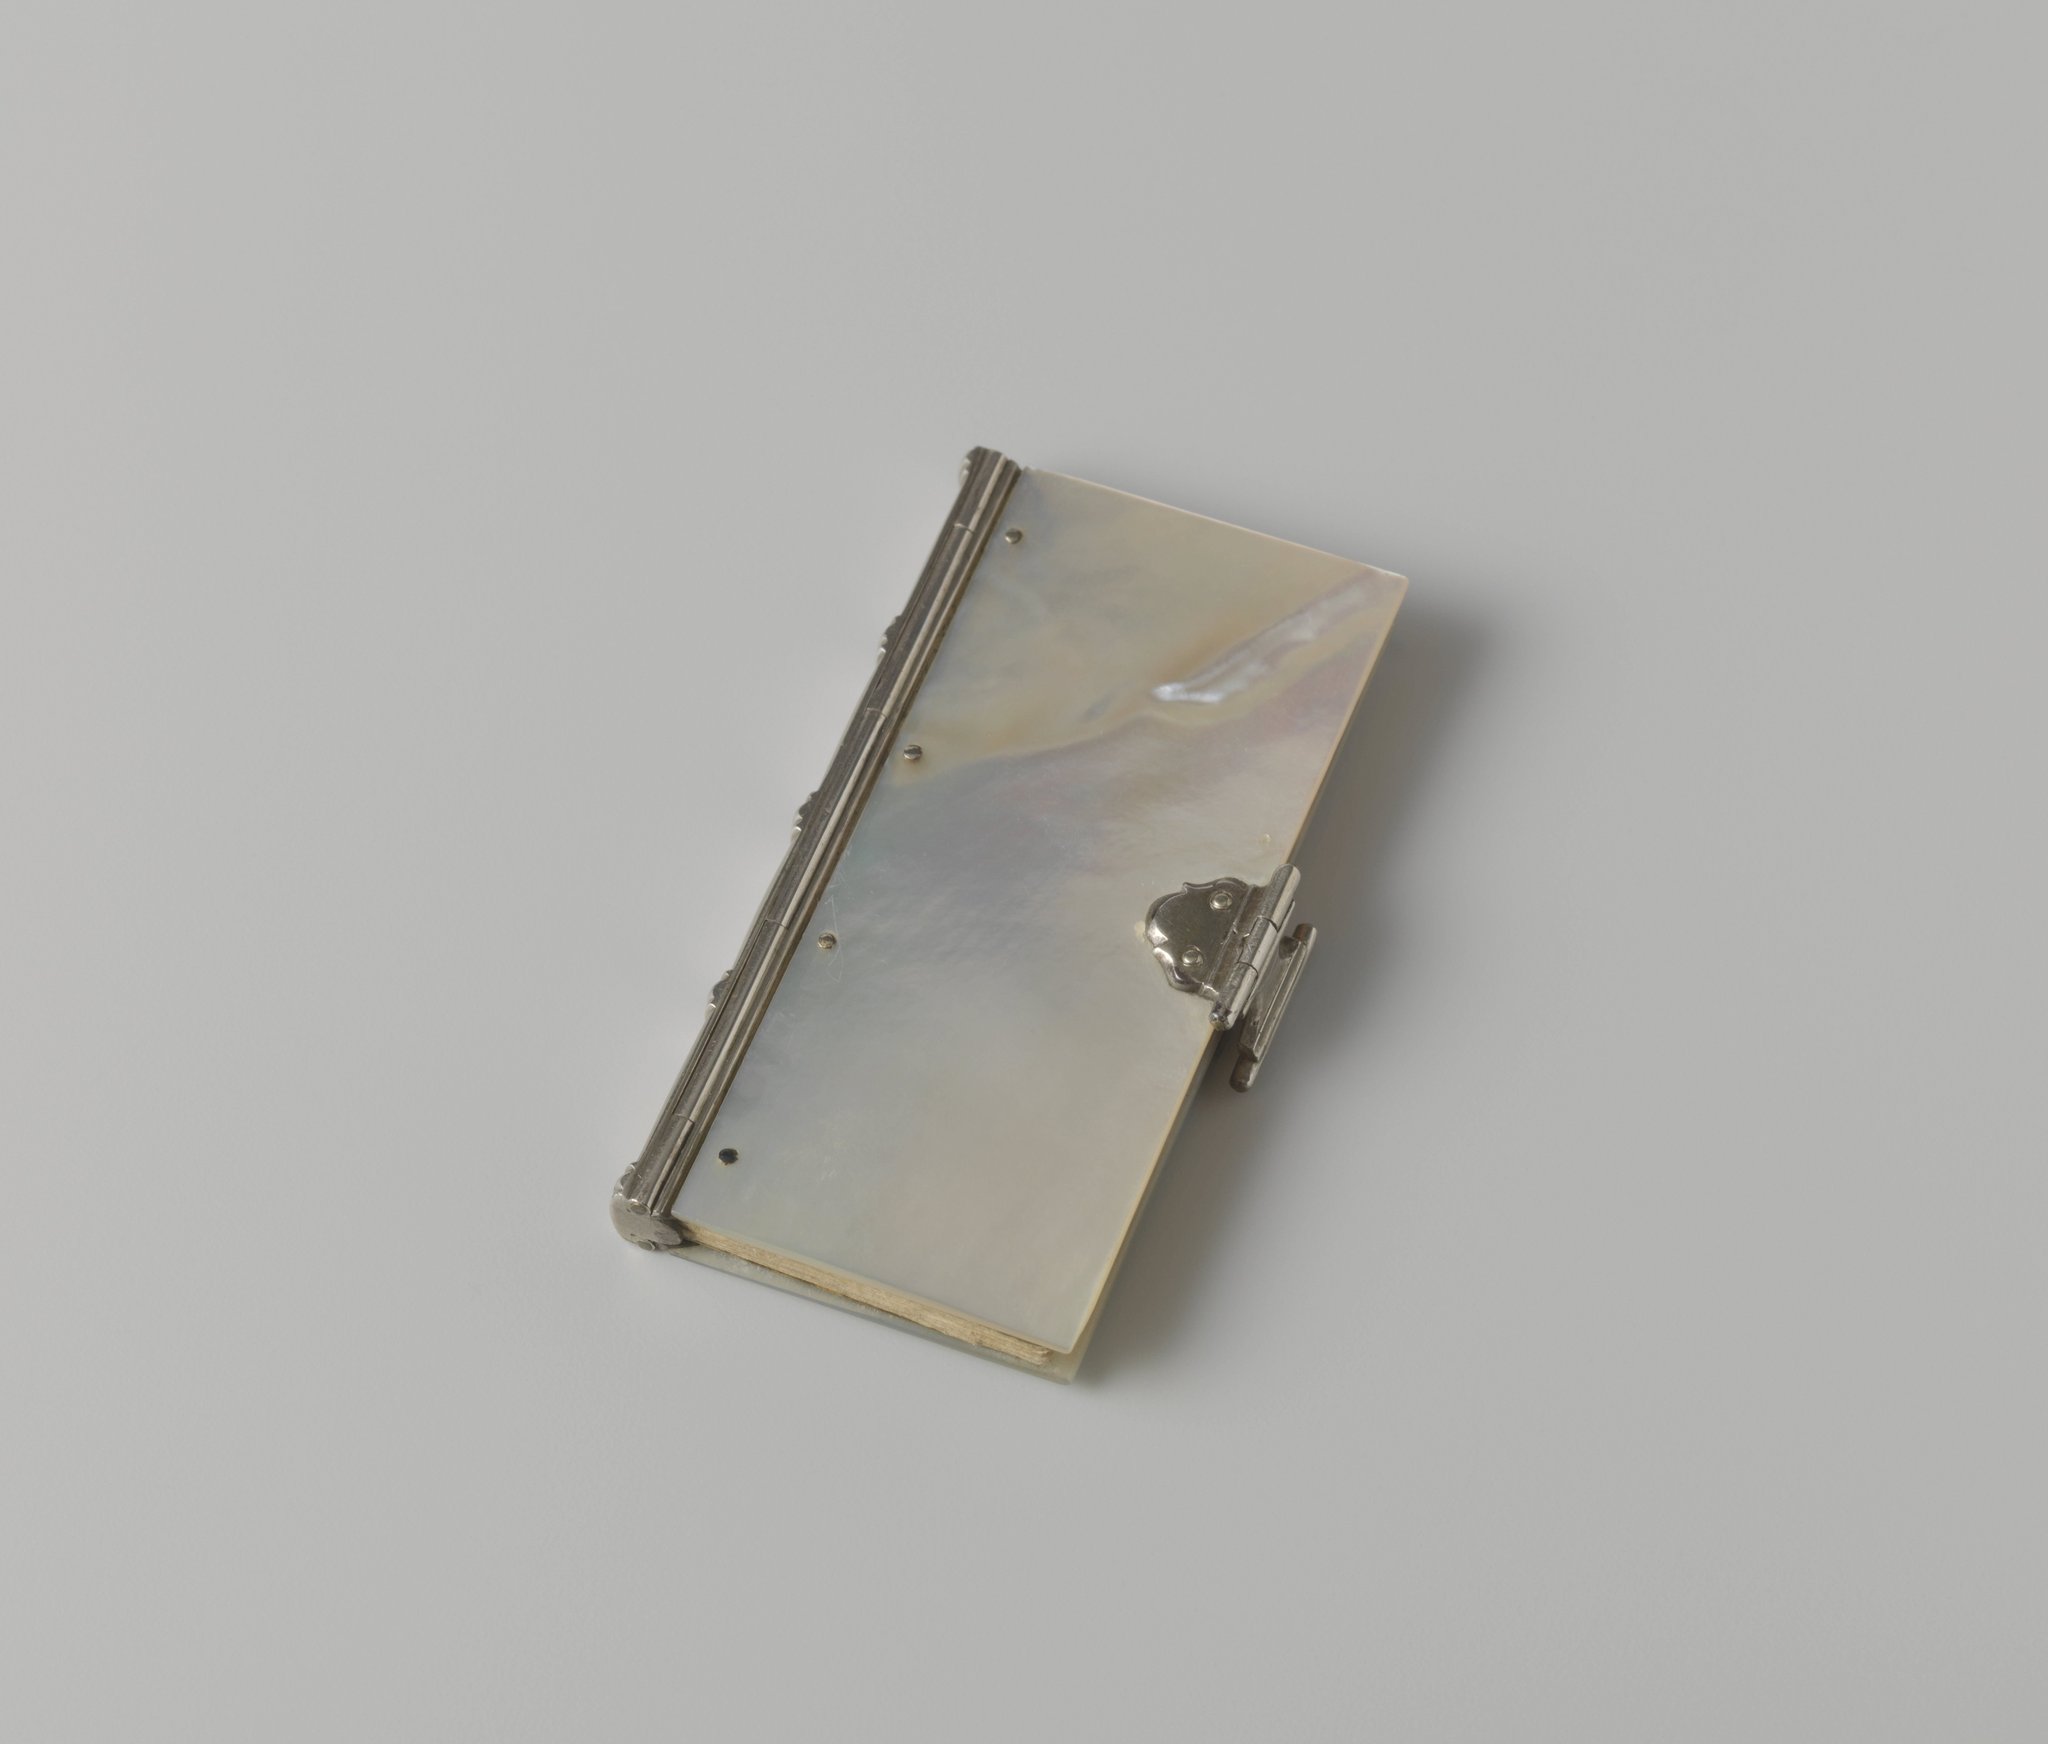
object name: miniature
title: Notitieboek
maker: Anonymous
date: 1788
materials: mother of pearl, silver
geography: amsterdam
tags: notebook